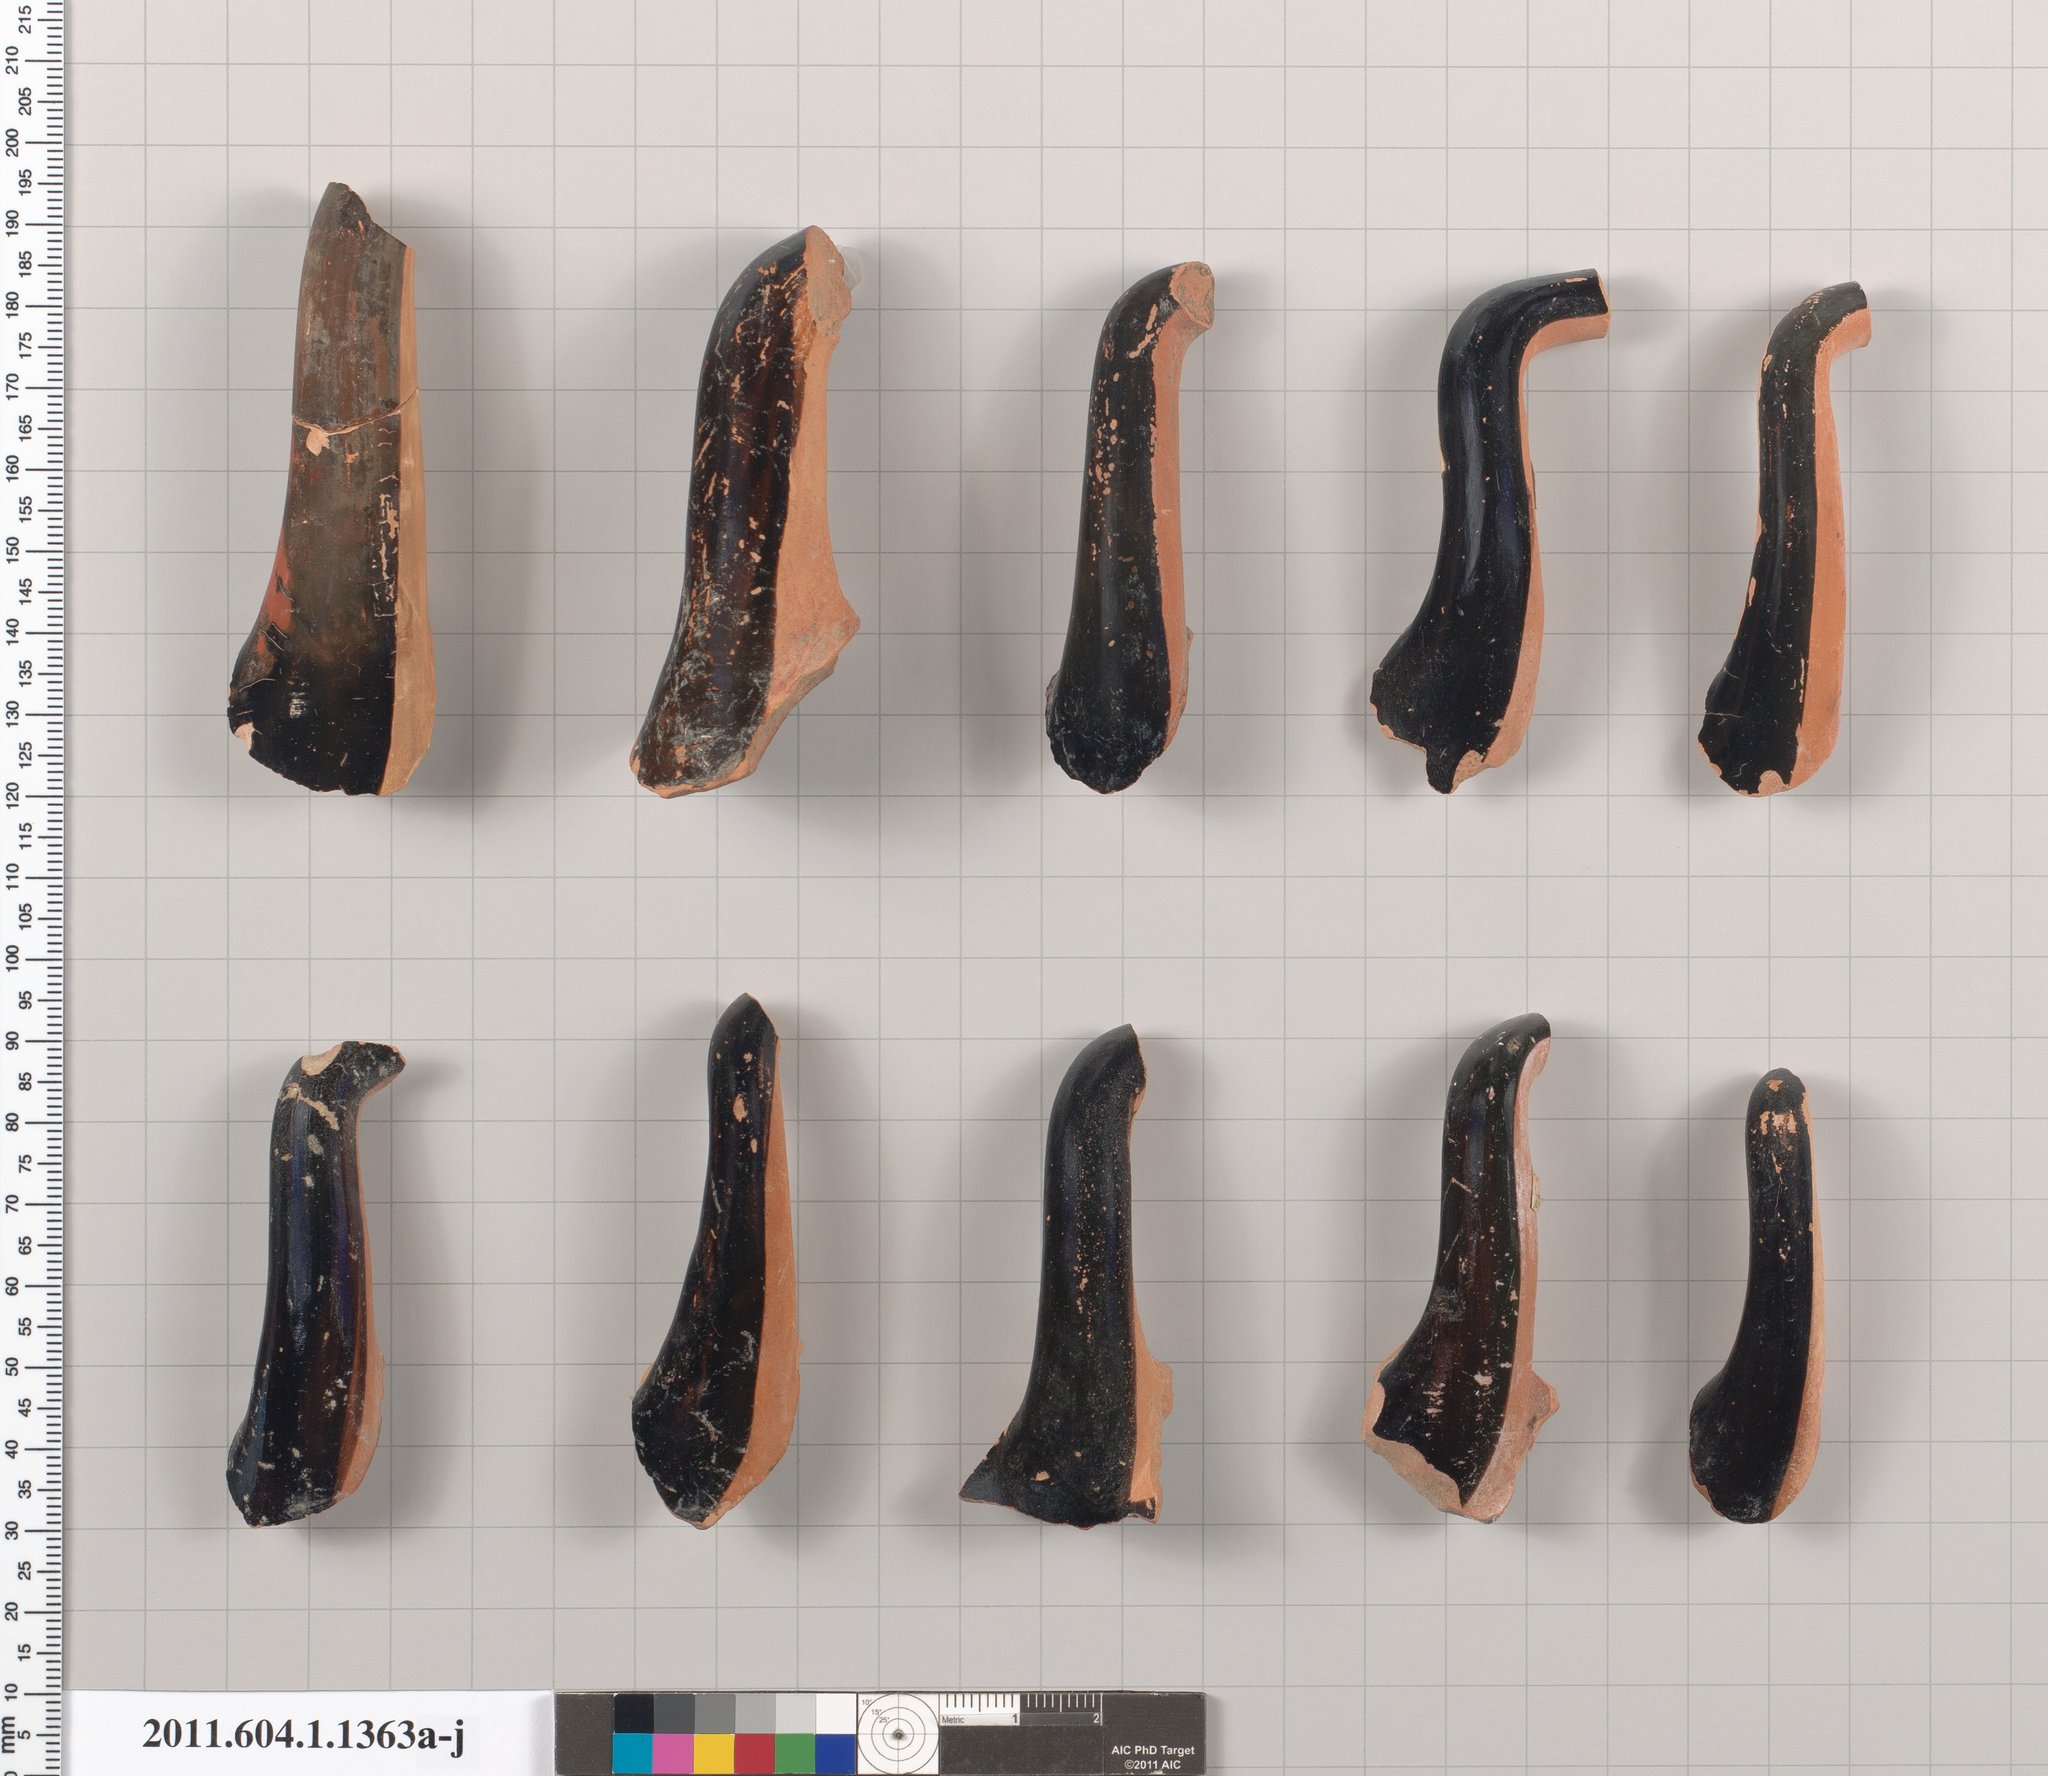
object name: kylix fragment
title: Terracotta fragments of kylikes (drinking cups)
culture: greek, attic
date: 500-401 BCE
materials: terracotta